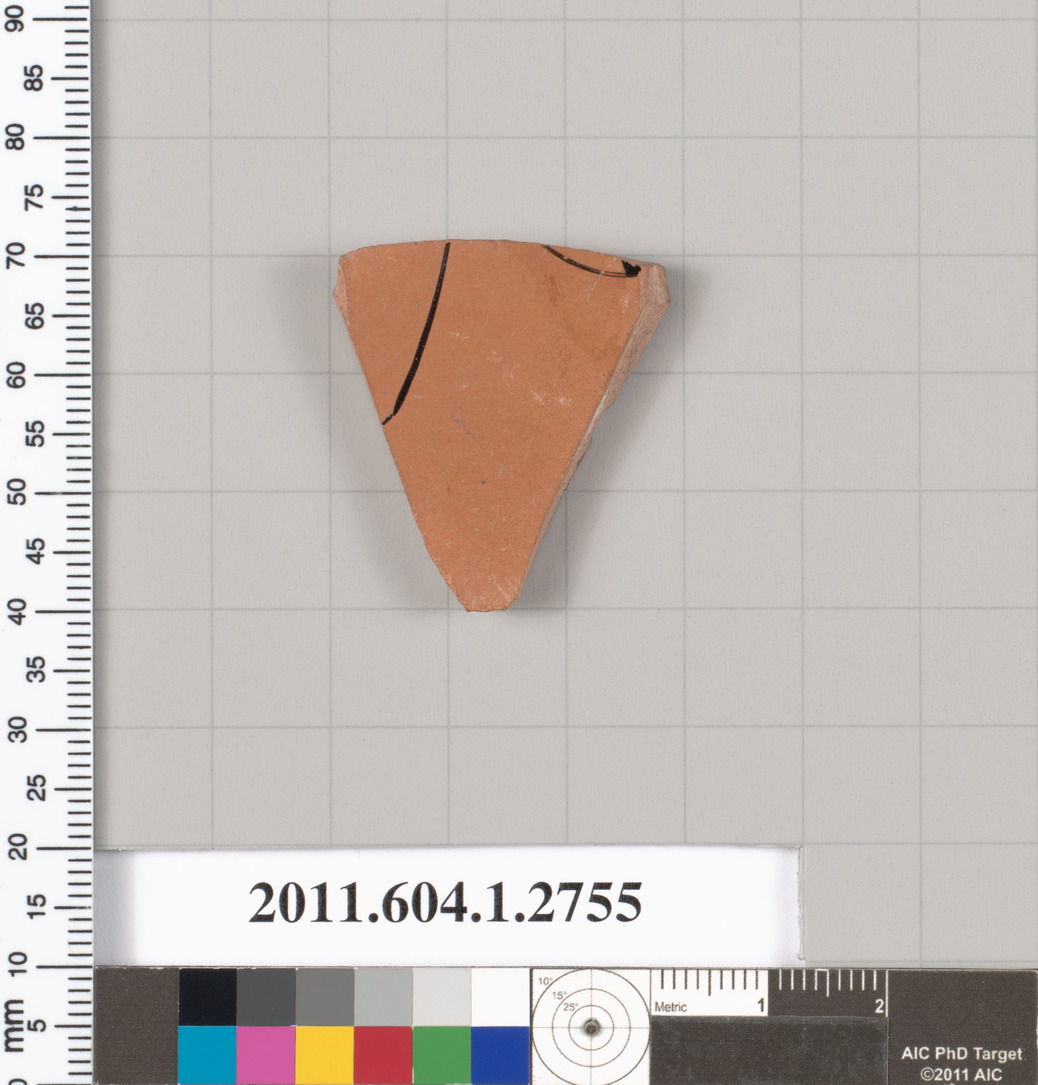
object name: kylix fragment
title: Terracotta fragment of a kylix (drinking cup)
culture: greek, attic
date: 500-476 BCE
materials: terracotta